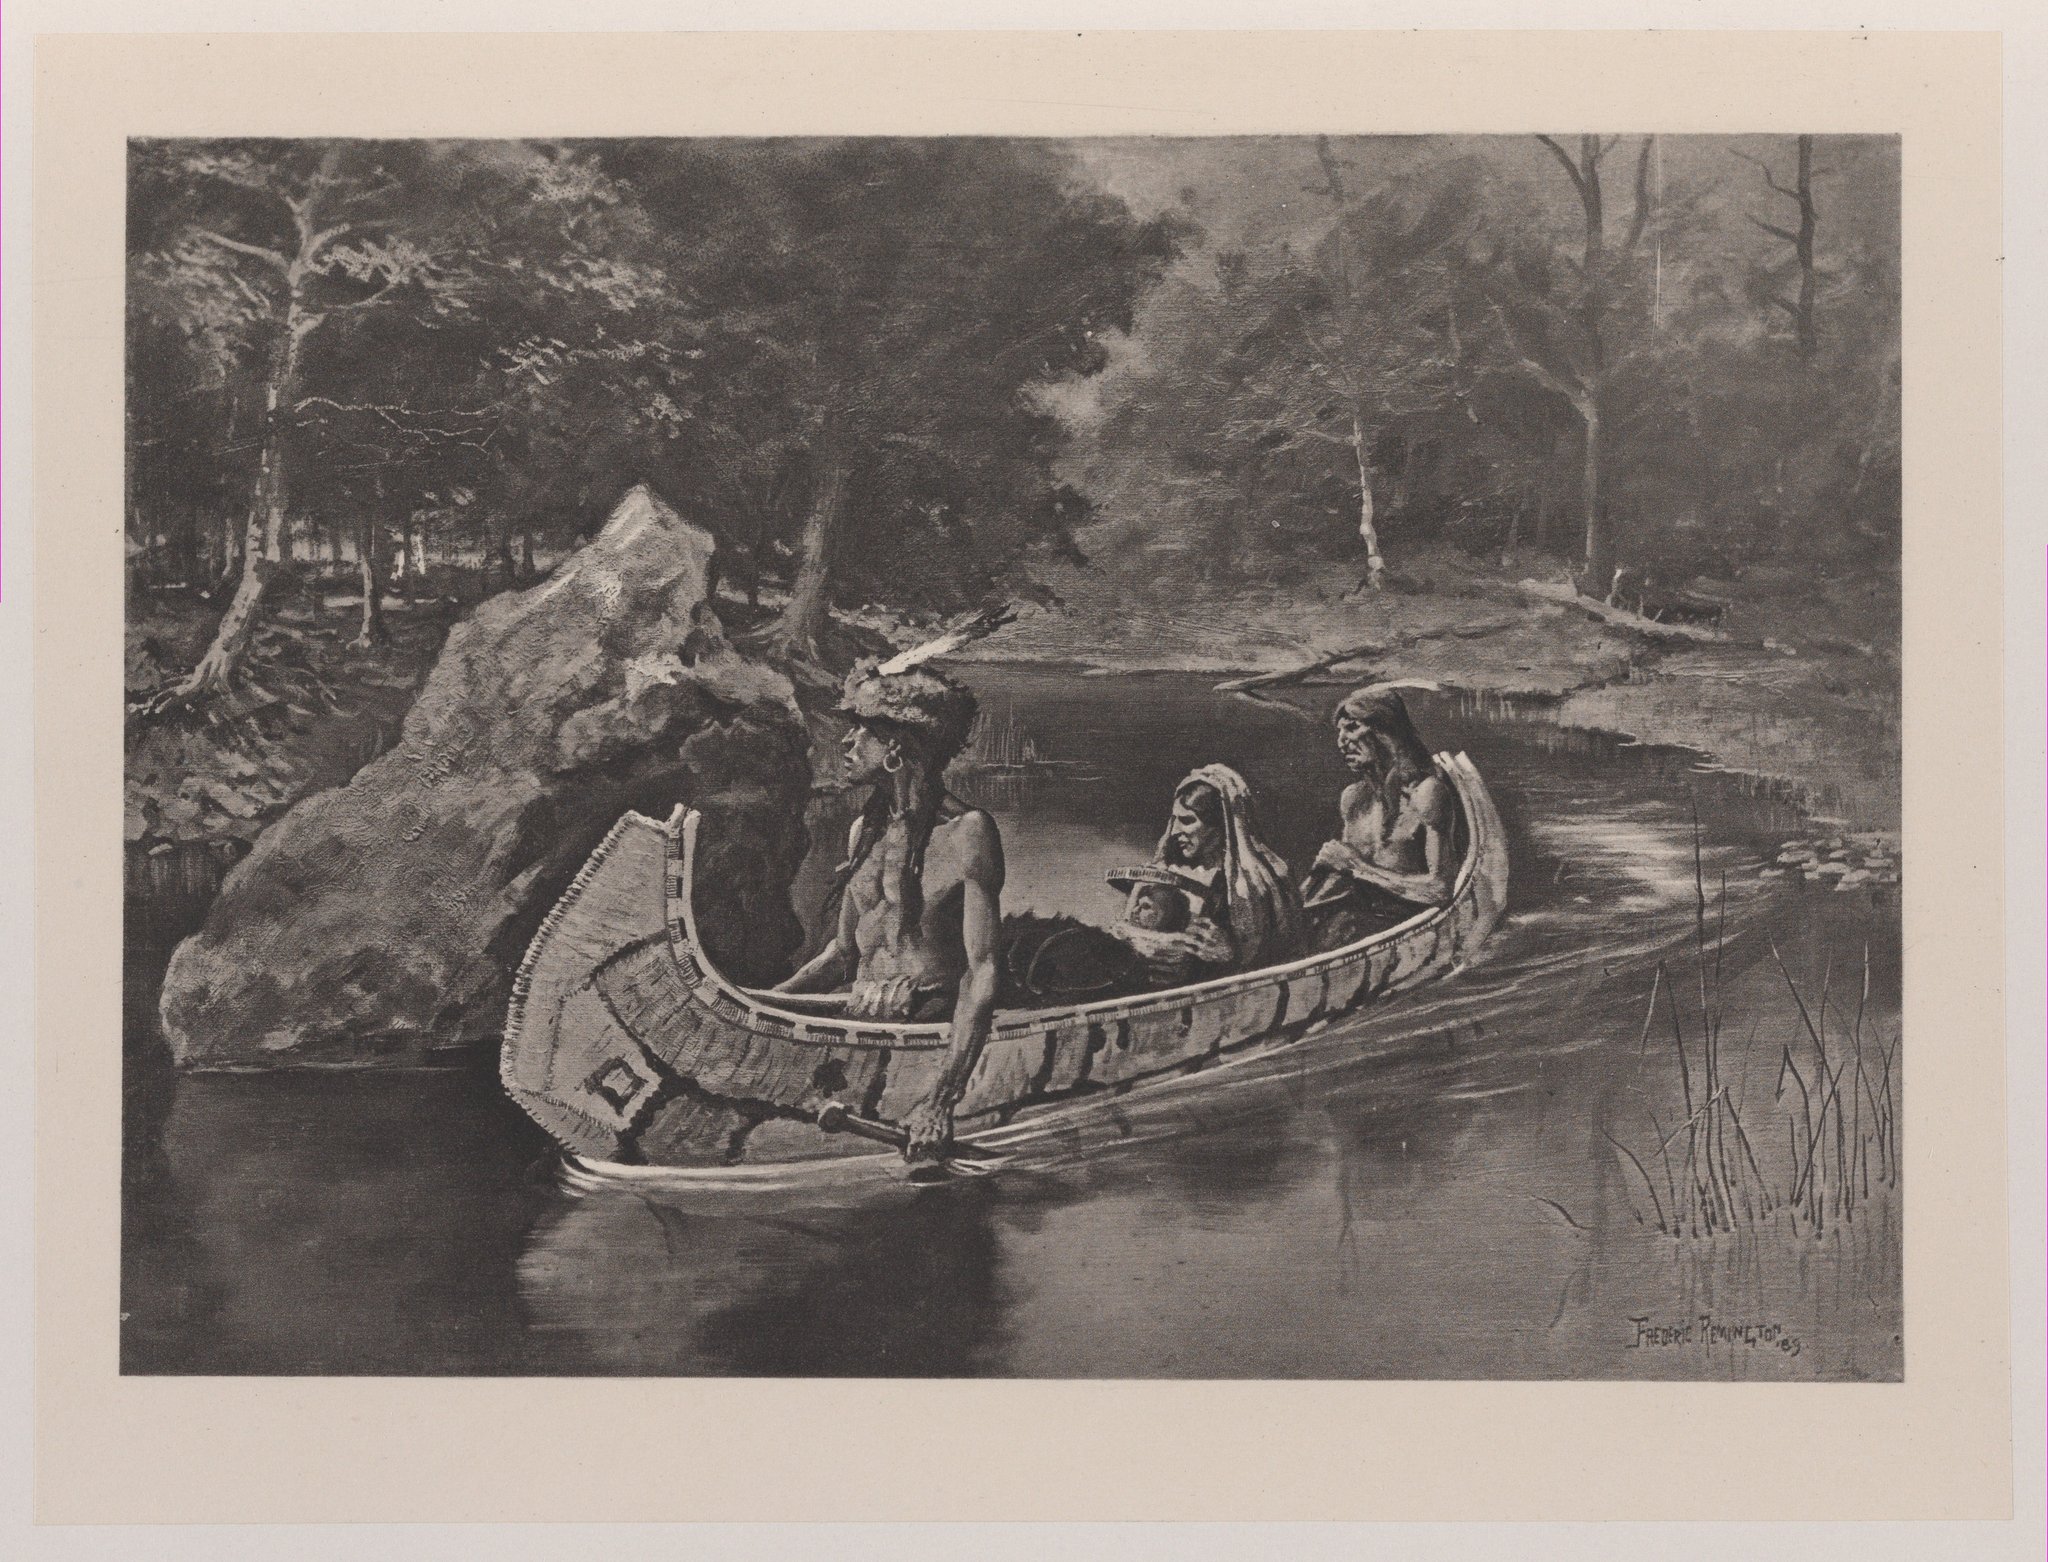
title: The song of Hiawatha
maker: henry wadsworth longfellow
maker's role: author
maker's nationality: american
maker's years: 1807-1882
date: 1891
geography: new york